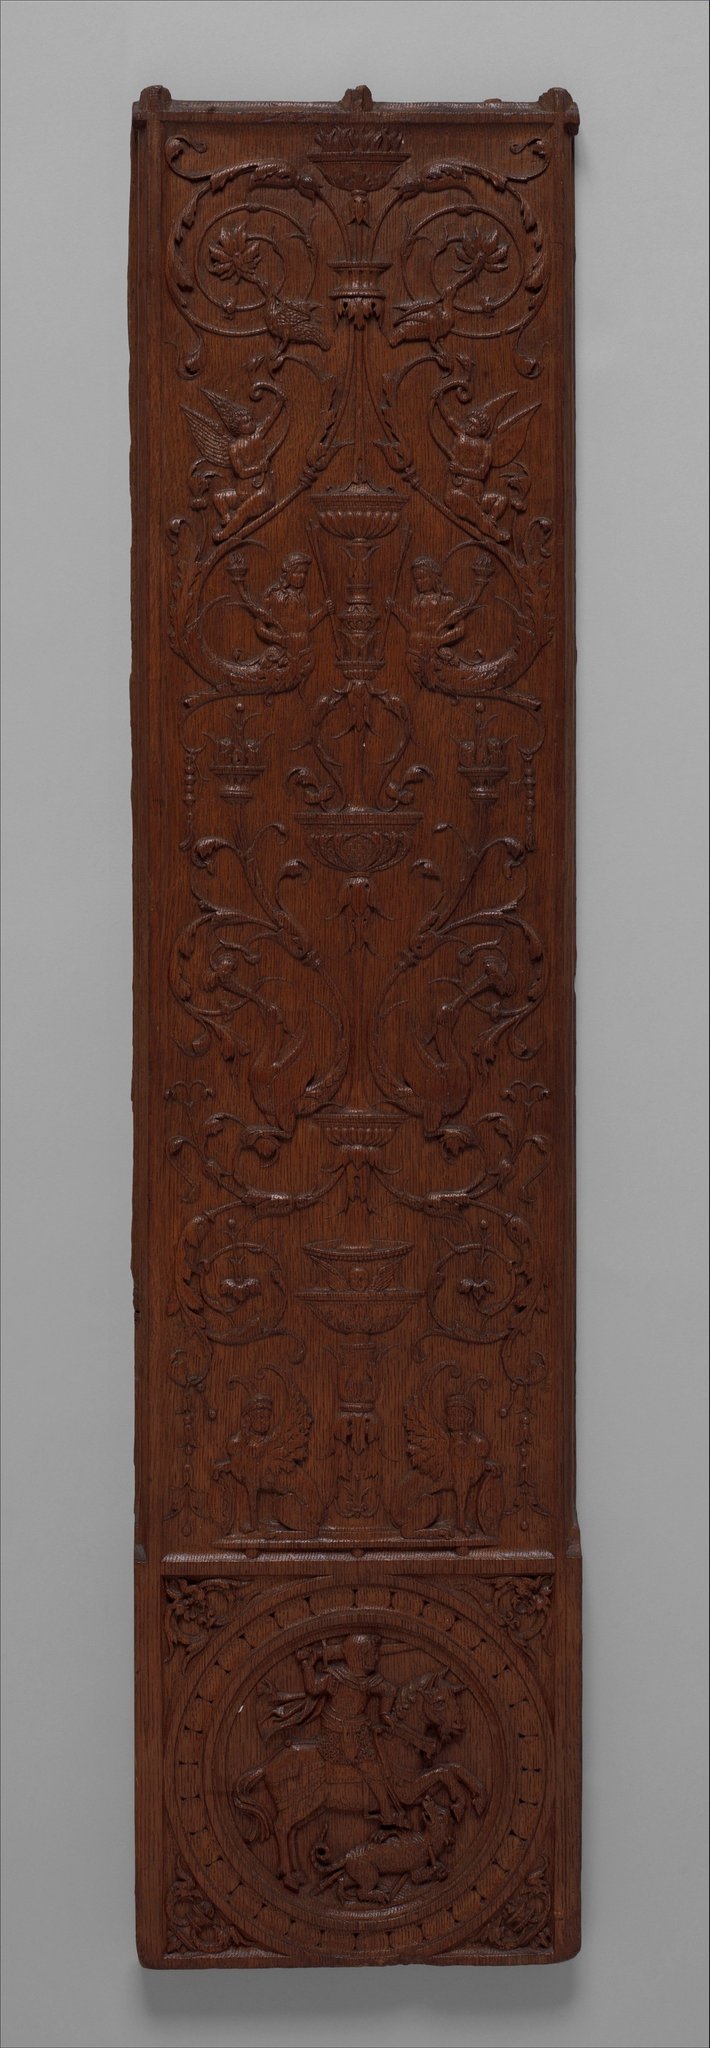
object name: choir screen panel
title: Choir screen panel (one of six)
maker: nicolas castille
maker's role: maker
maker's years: 1503-1521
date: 1508-1510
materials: wood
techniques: carving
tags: dragons,horses